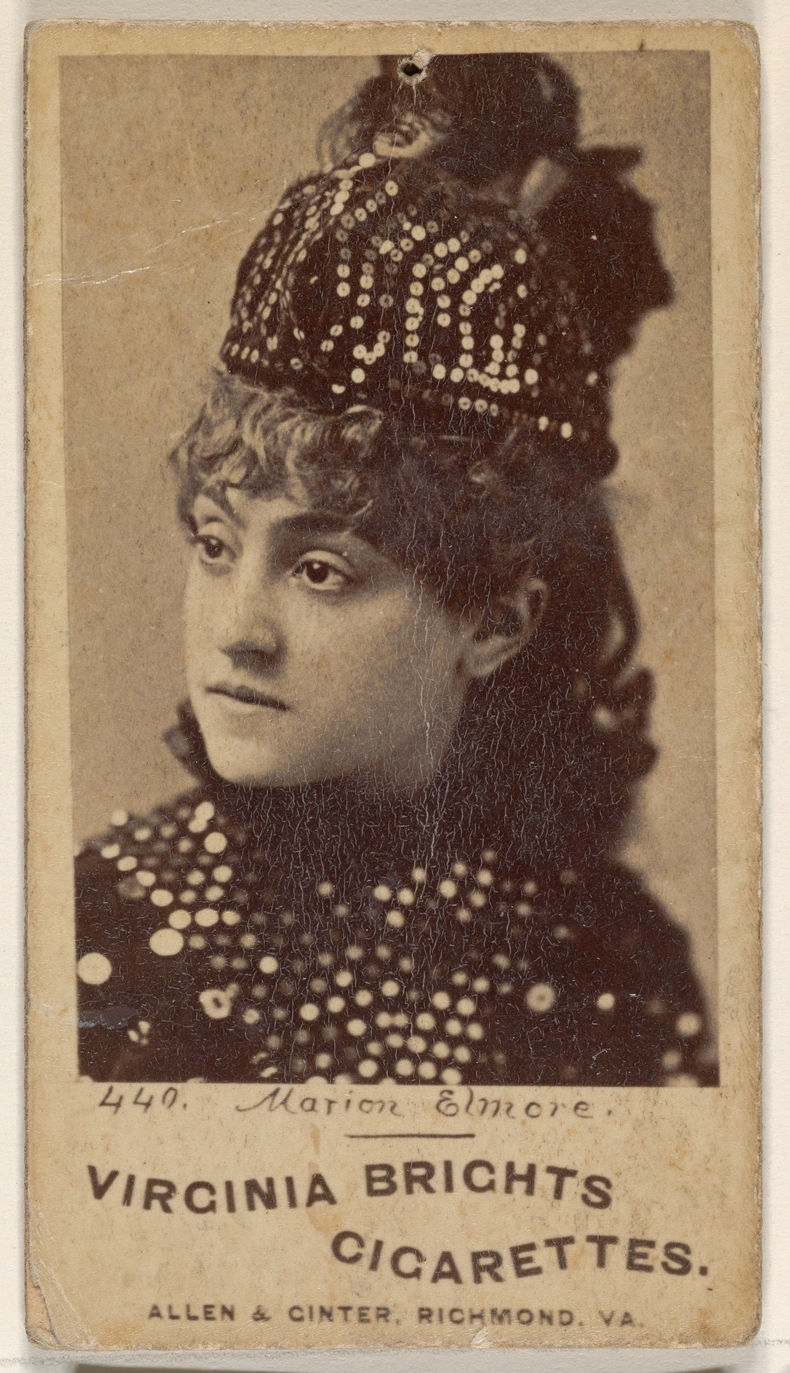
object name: photograph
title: Card 449, Marion Elmore, from the Actors and Actresses series (N45, Type 1) for Virginia Brights Cigarettes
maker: allen & ginter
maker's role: publisher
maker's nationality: american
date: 1888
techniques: albumen silver print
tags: portraits,women,actresses